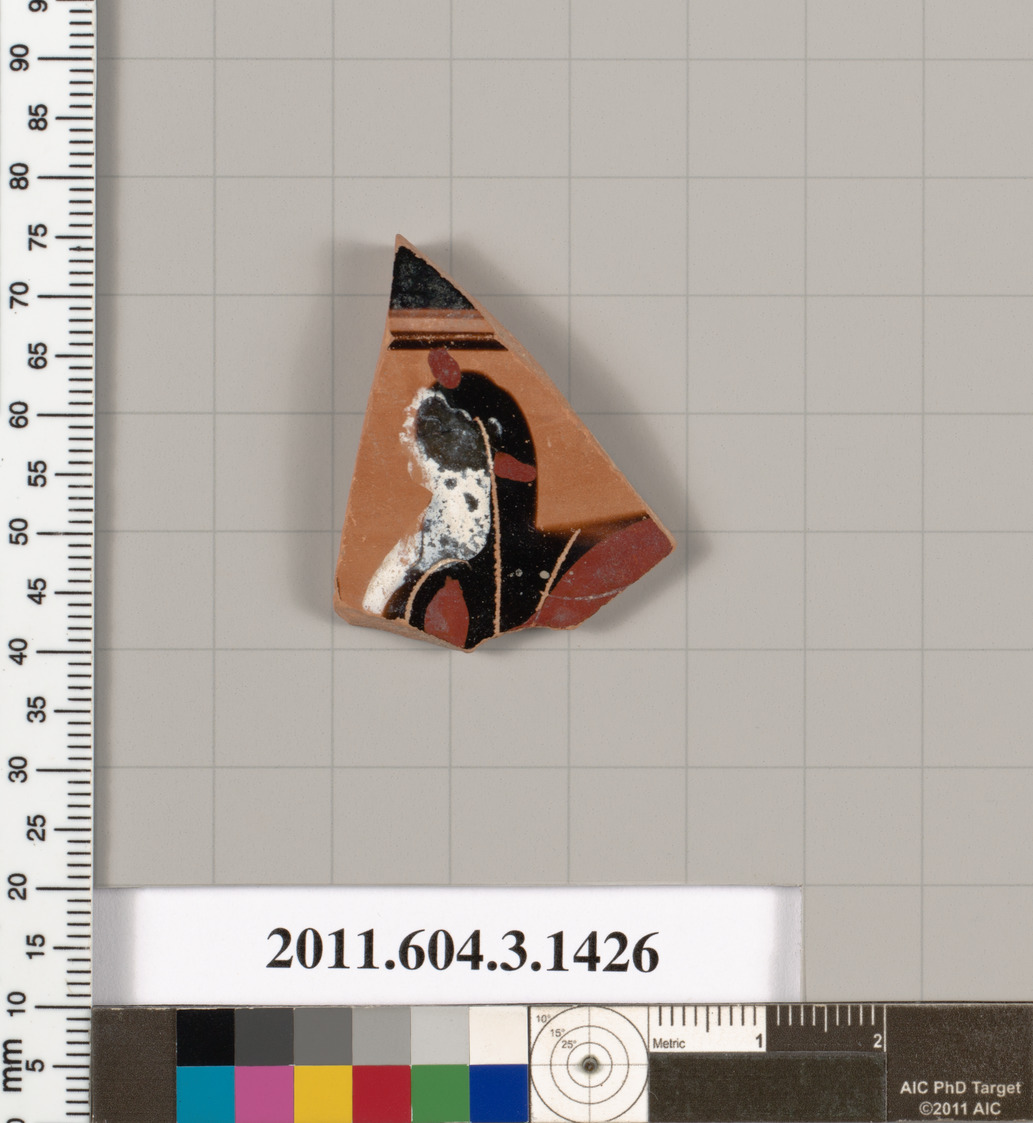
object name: skyphos fragment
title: Terracotta fragment of a skyphos (deep drinking cup)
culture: greek, attic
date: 500-468 BCE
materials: terracotta